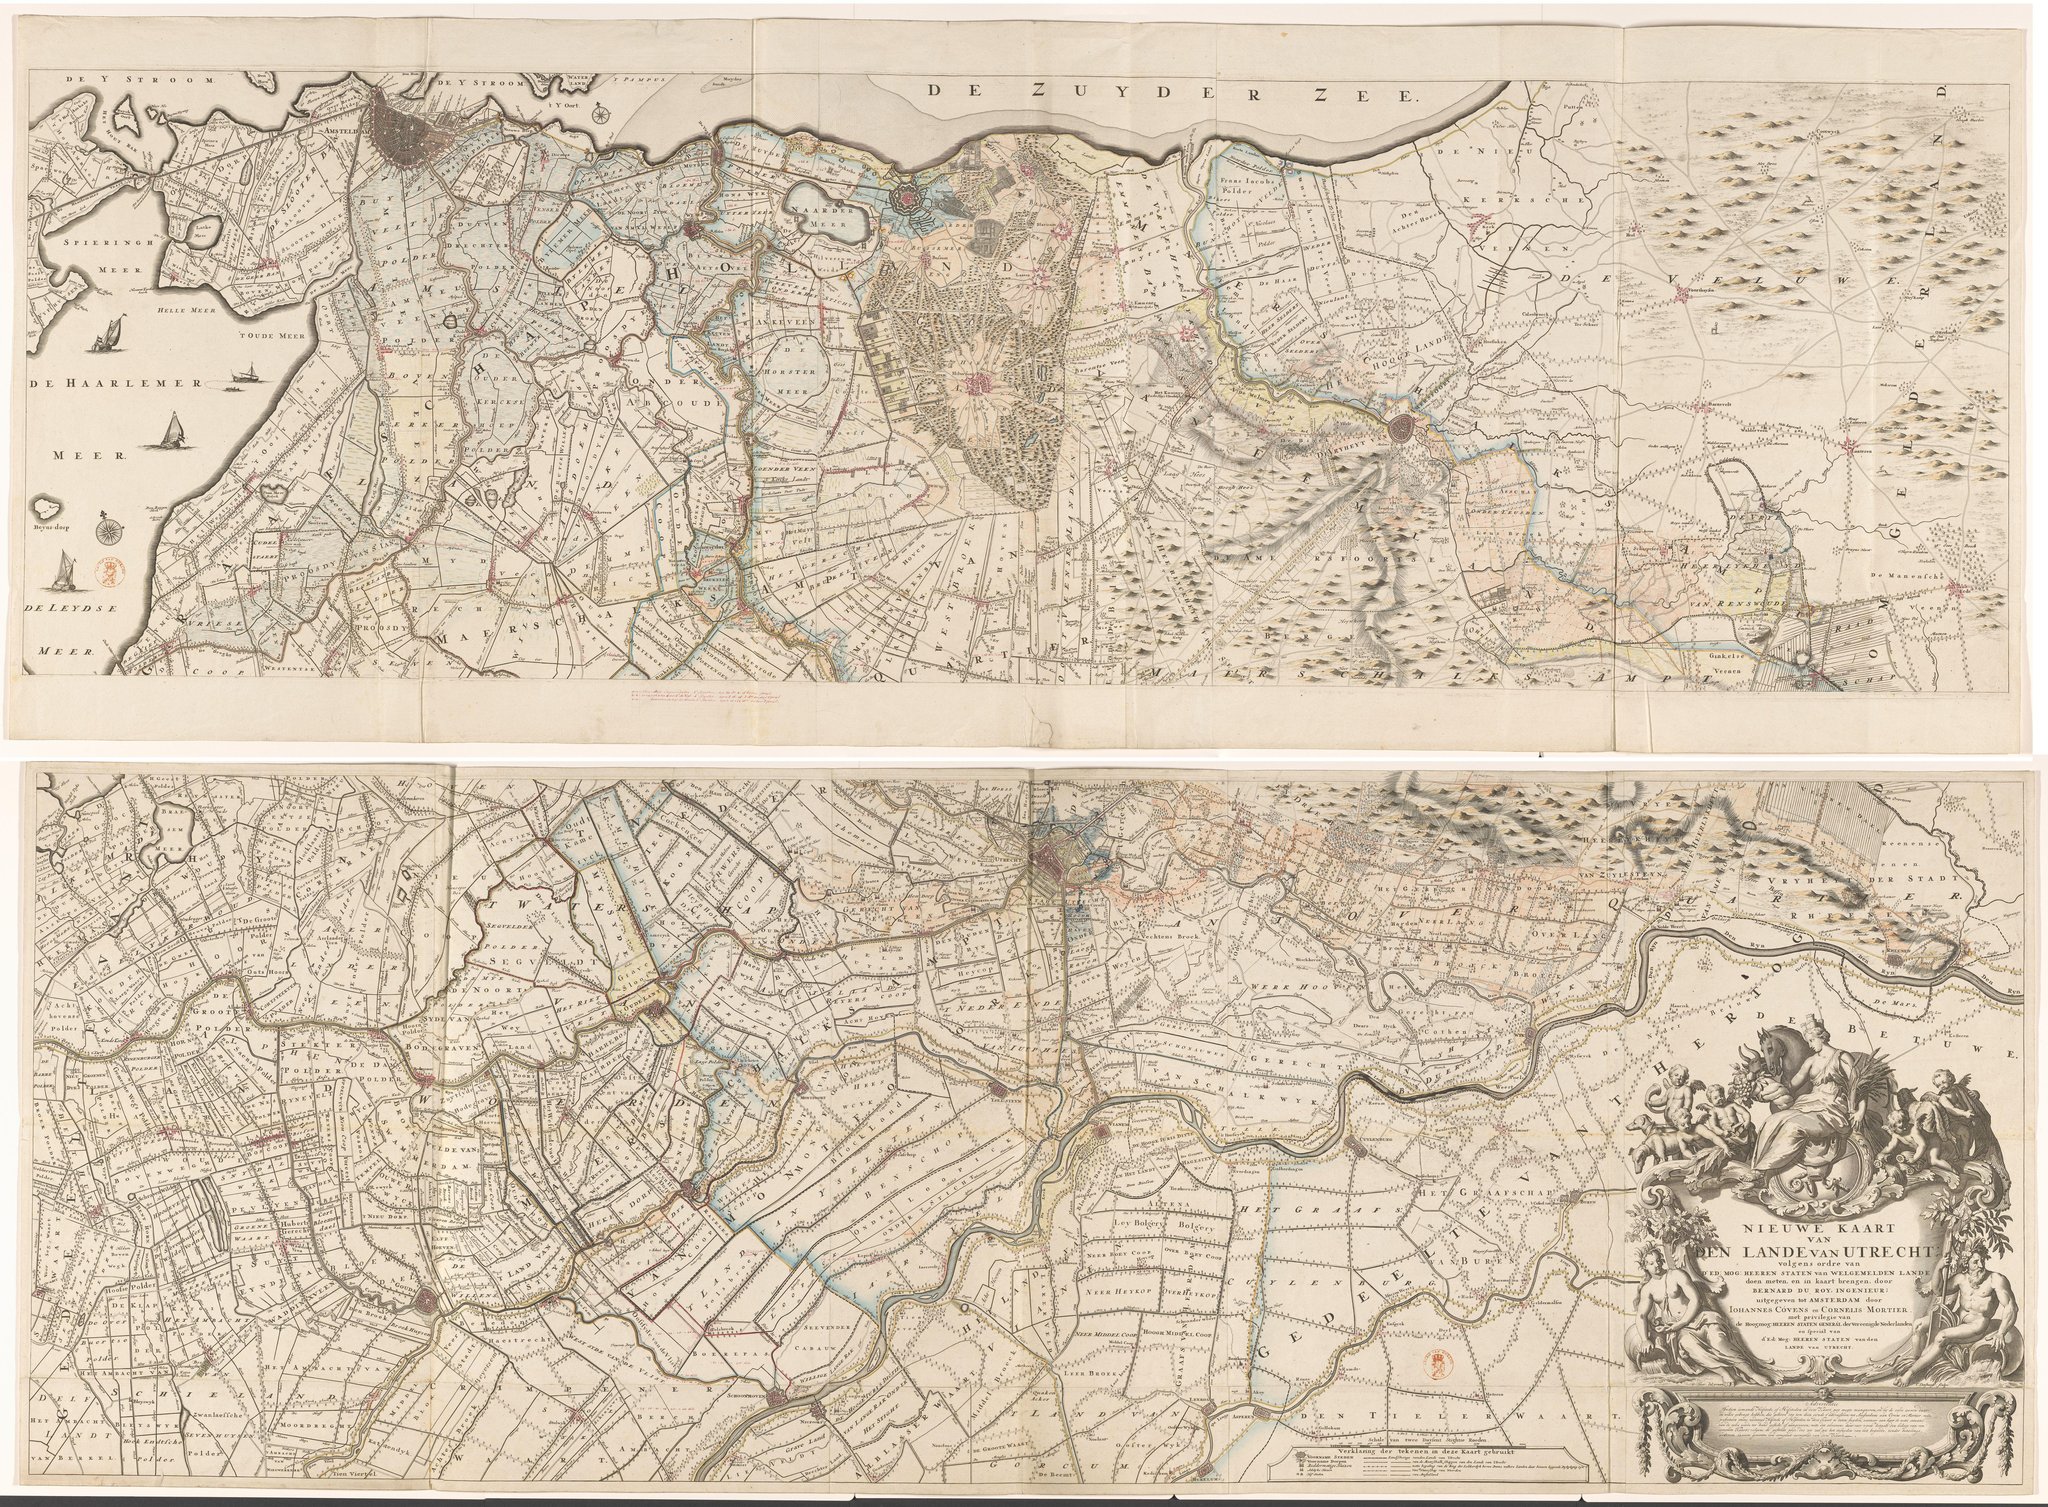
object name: map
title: Kaart van de provincie Utrecht, bestaande uit twee delen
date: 1696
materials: paper, pencil, watercolor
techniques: brush, engraving, etching, pen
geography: utrecht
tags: coat of arms (as symbol of the state, etc.), peat-cutting, maps of separate countries or regions, hunting, chase, cattle, river-gods, fishing (sports), agriculture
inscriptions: collector's mark: Lugt 19, inscription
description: Rechtsonder de titelcartouche met een variant van het wapen van het aartsbisdom Utrecht. Boven het wapen een vrouwfiguur met op haar hoofd vier torens, in haar ene hand de hoorn des overvloeds en in haar andere hand een korenschoof. Verder om de cartouche heen een riviergod met een vrouwelijke tegenhangster en putti met attributen die verwijzen naar de jacht, landbouw, turfwinning en visserij. Onder de cartouche een advertentie van de drukker. Links van de cartouche een legenda en een schaalstok: Schale van twee duysent Stightse roeden. Op de kaart zijn verschillende handgeschreven aanvullingen aangebracht.